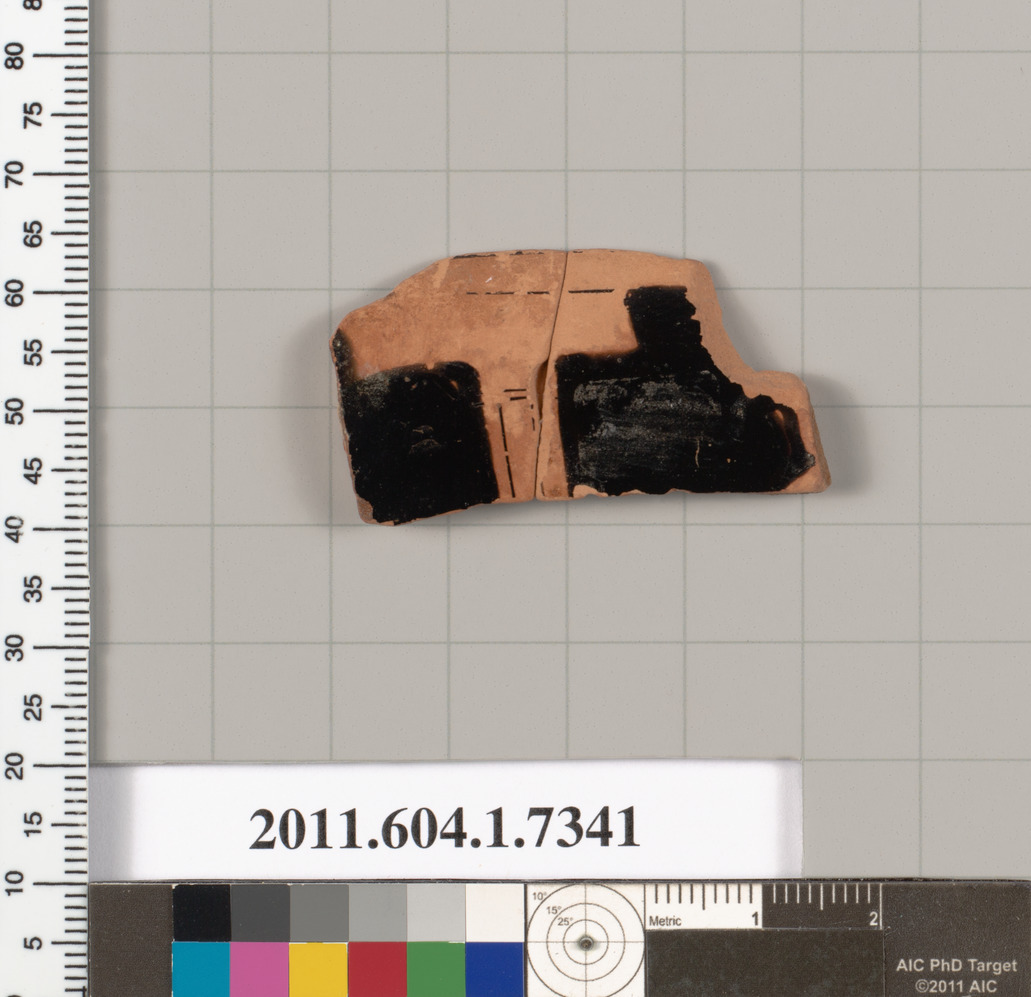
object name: kylix fragment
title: Terracotta rim fragment of a kylix (drinking cup)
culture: greek, attic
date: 500-480 BCE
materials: terracotta